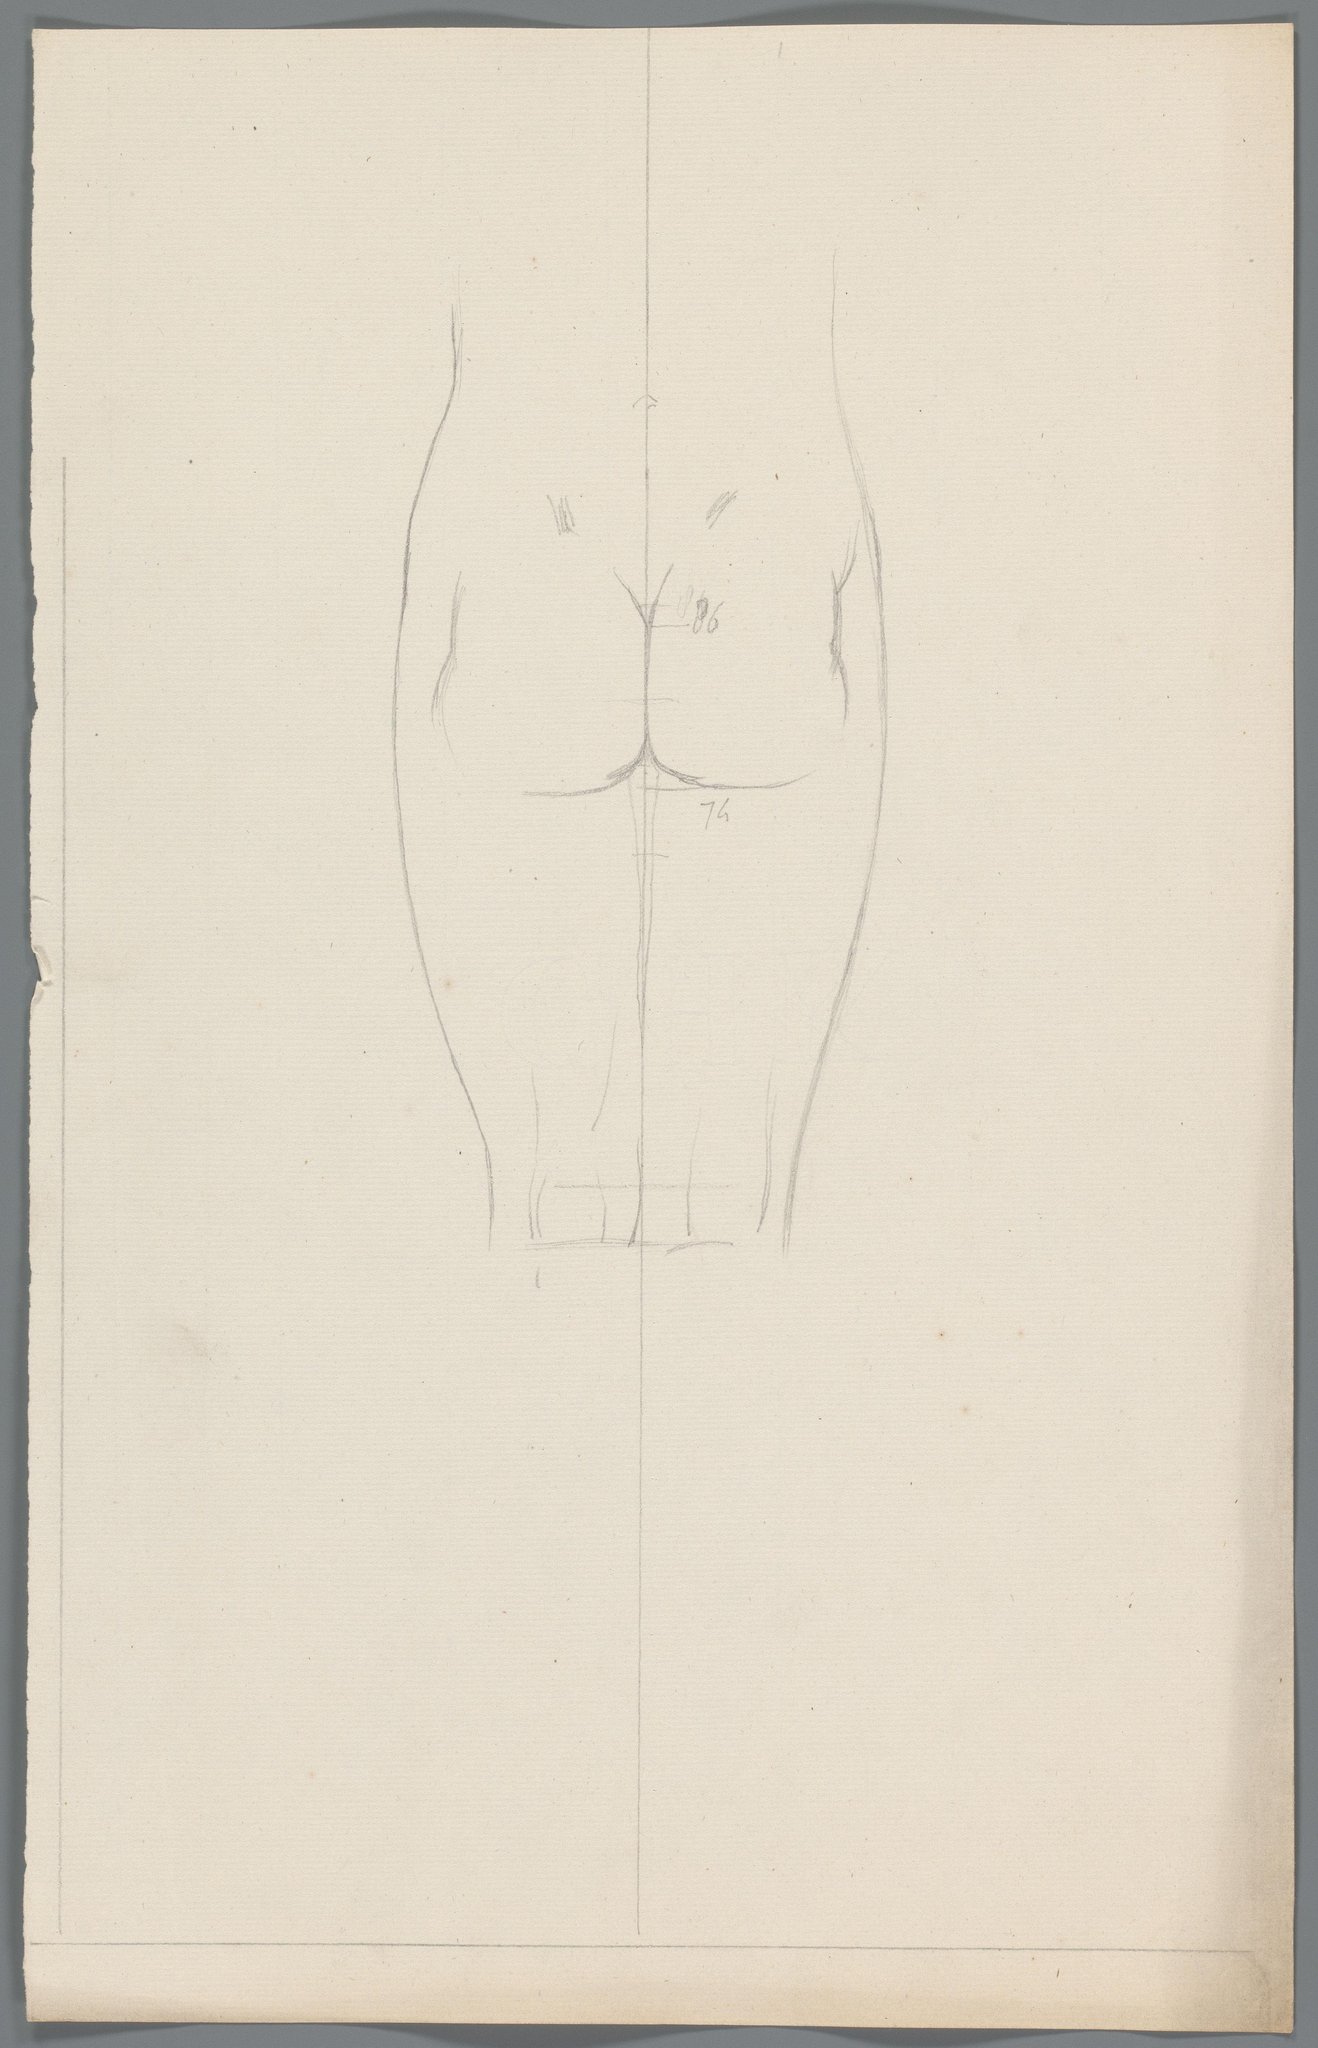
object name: drawing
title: Studie van billen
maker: jacobus everhardus josephus van den berg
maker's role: draughtsman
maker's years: 1802-1861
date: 1812-1861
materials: paper, pencil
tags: buttocks, 'partes posteriores'